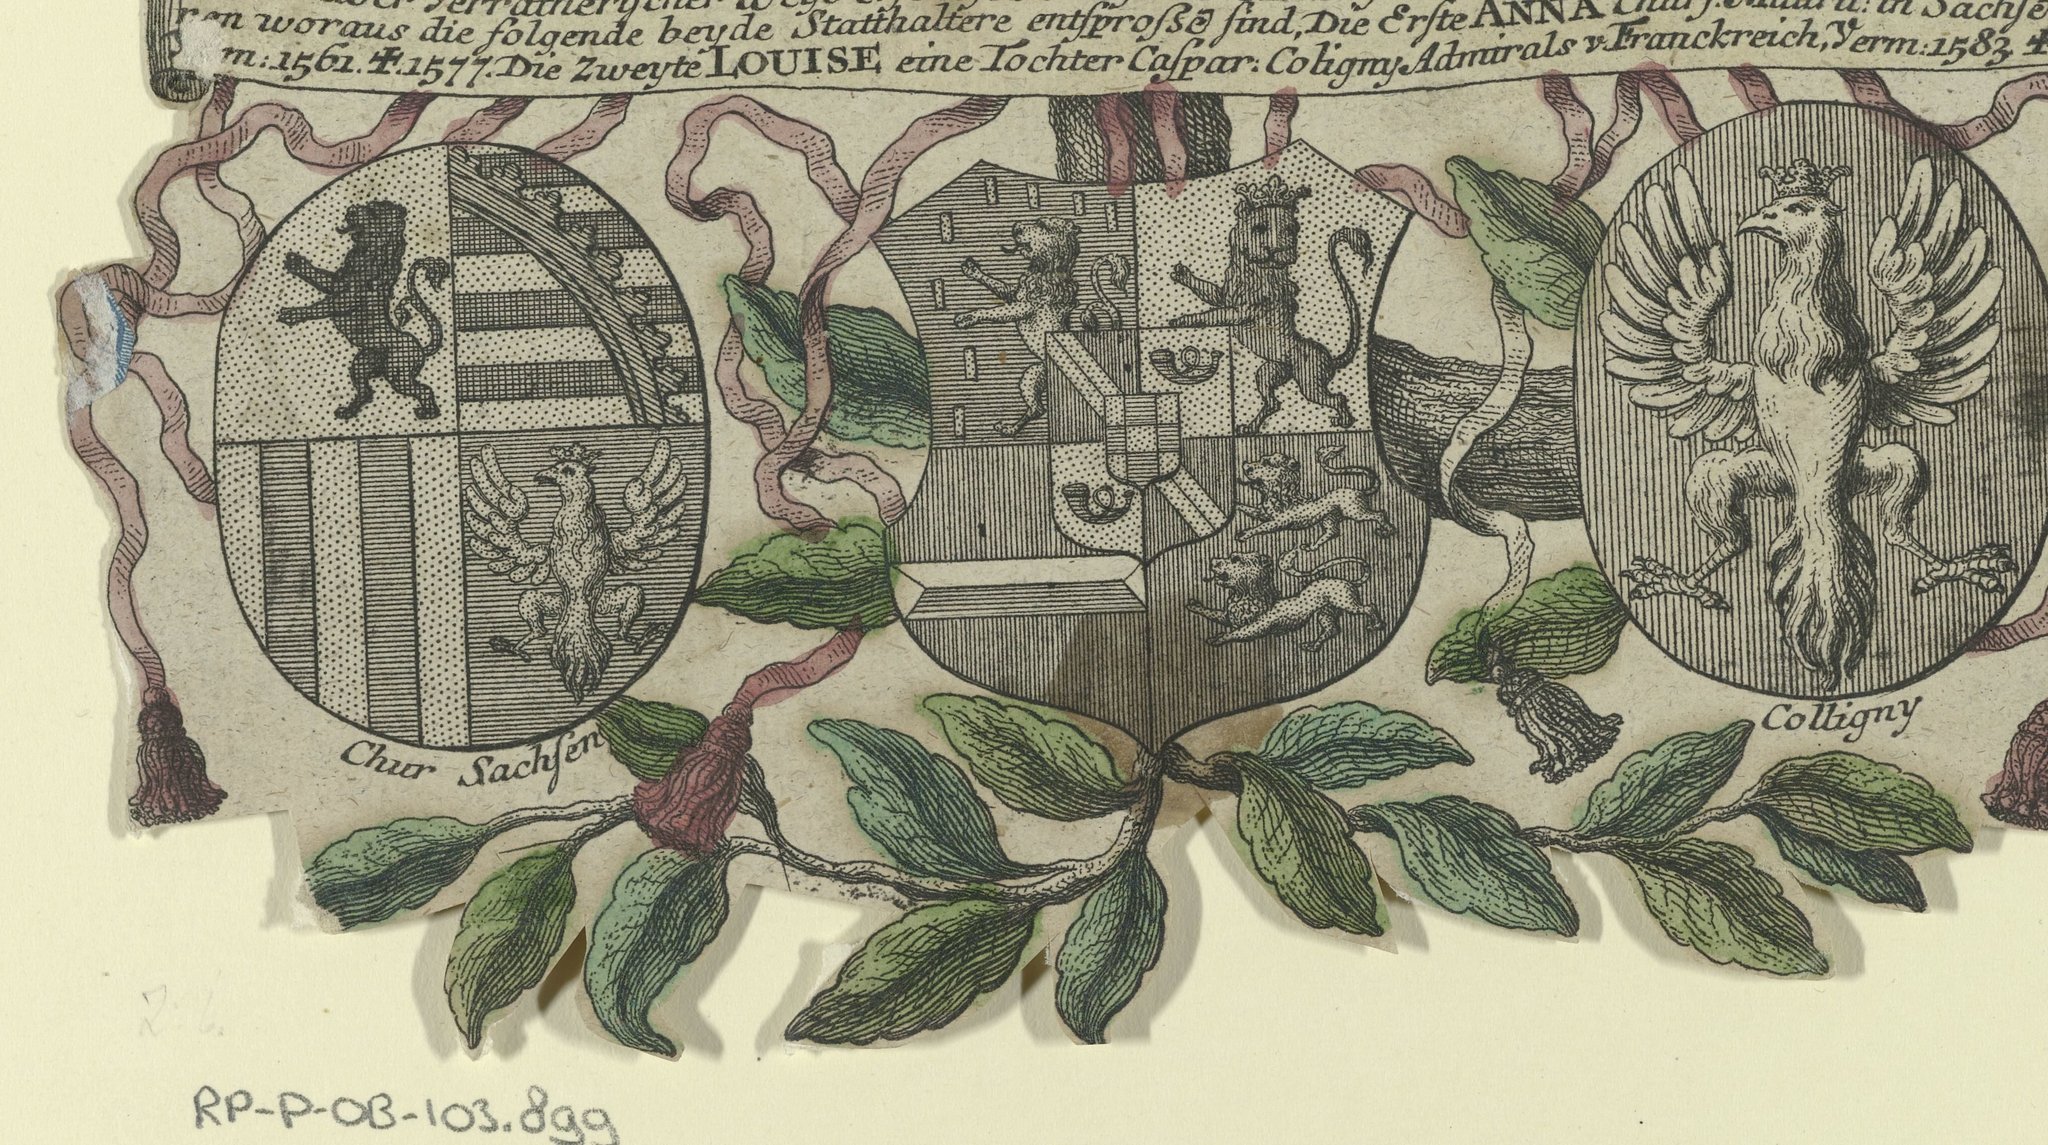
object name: print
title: Wapens van Willem I, prins van Oranje, Anna van Saksen en Louise de Coligny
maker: Anonymous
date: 1750-1849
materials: paper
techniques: engraving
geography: low countries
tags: louise de coligny, delft, william i (prince of orange)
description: Wapens van Willem I, Anna en Louise. In een cartouche zes regels Nederlandse tekst.